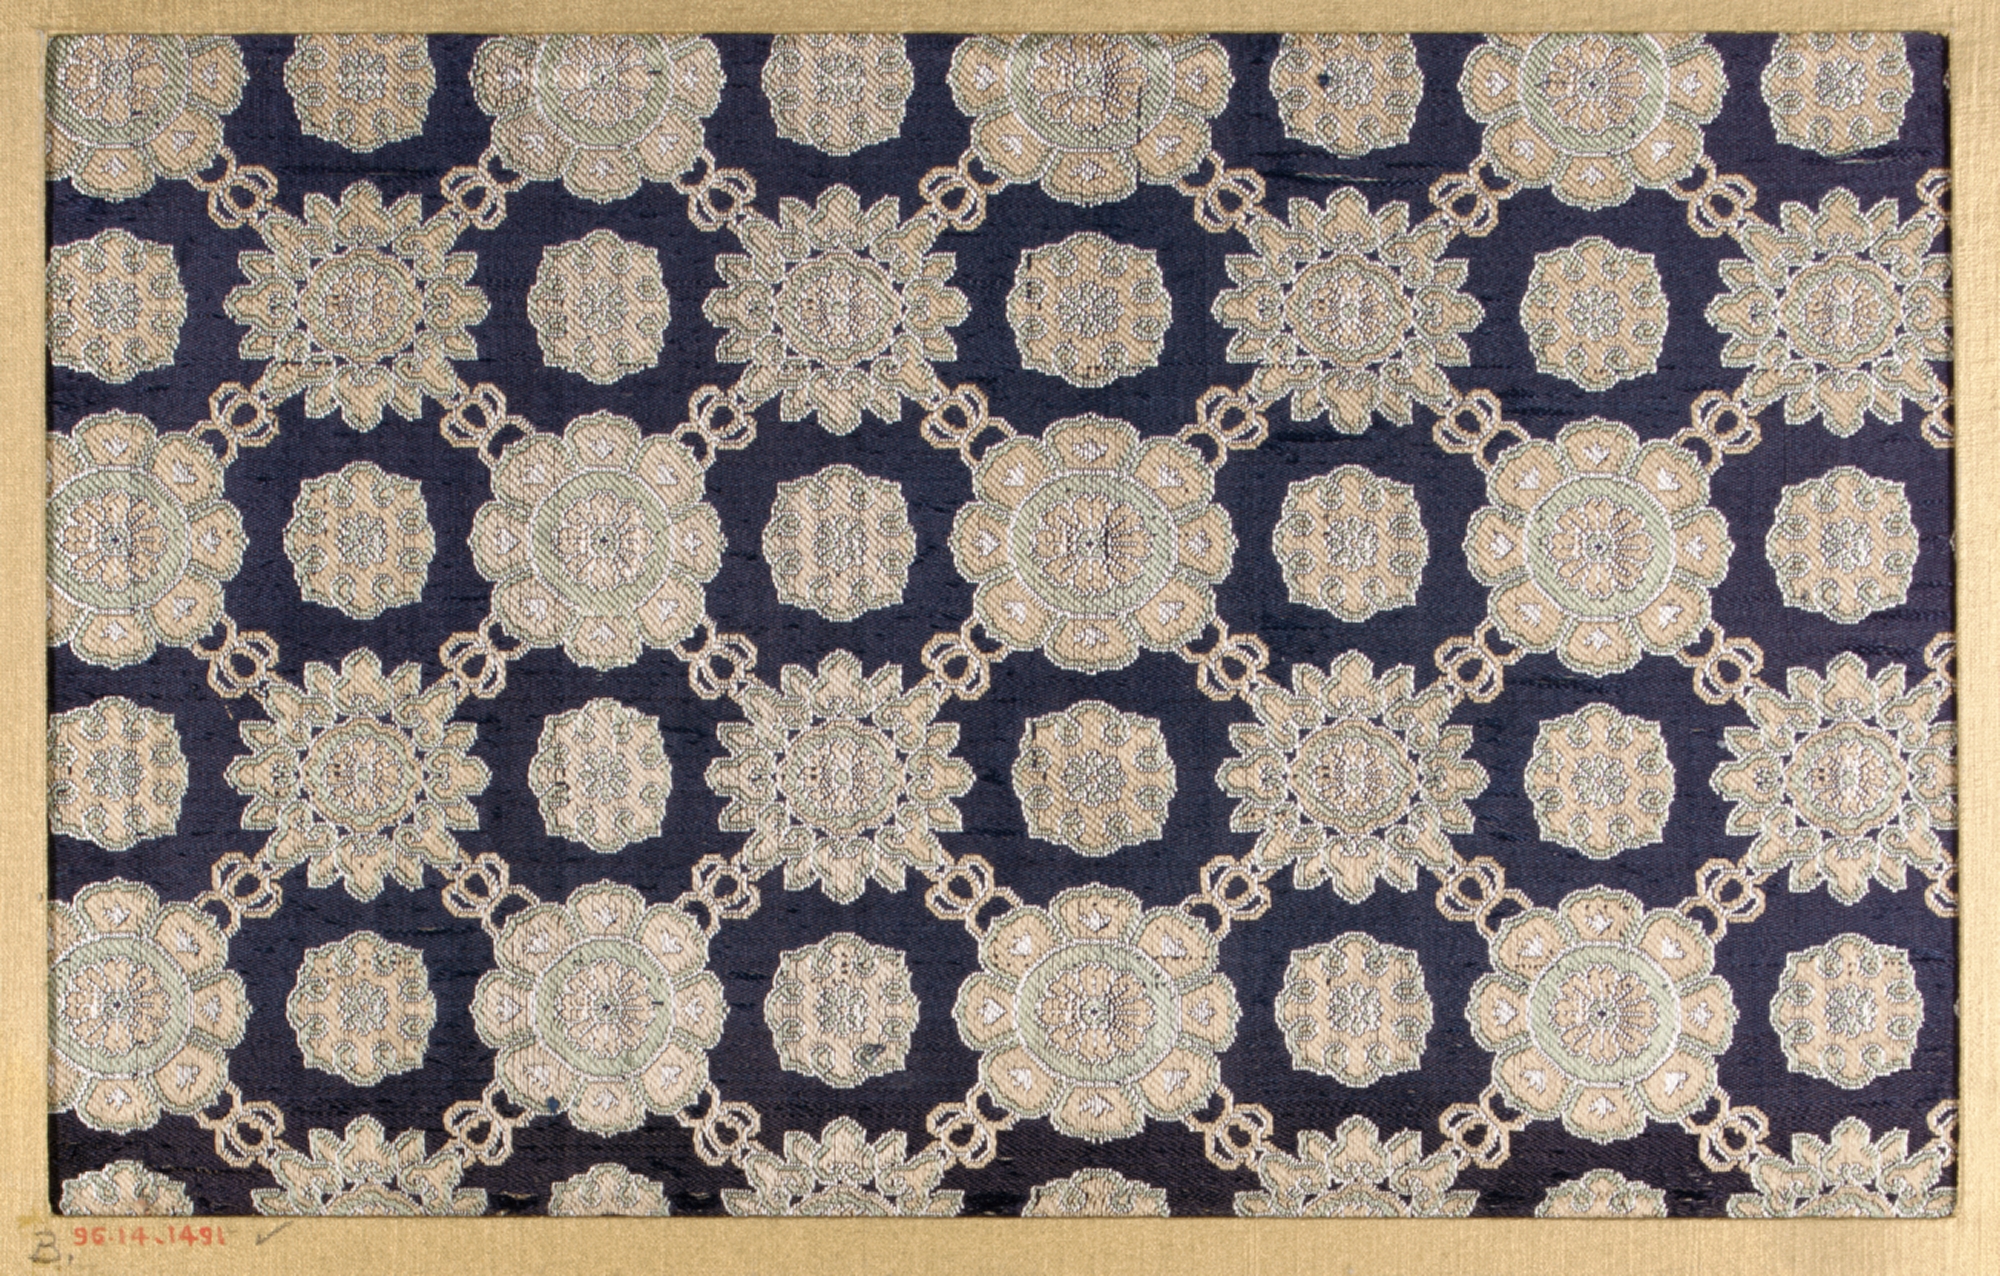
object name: piece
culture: japanese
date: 1701-1900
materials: silk